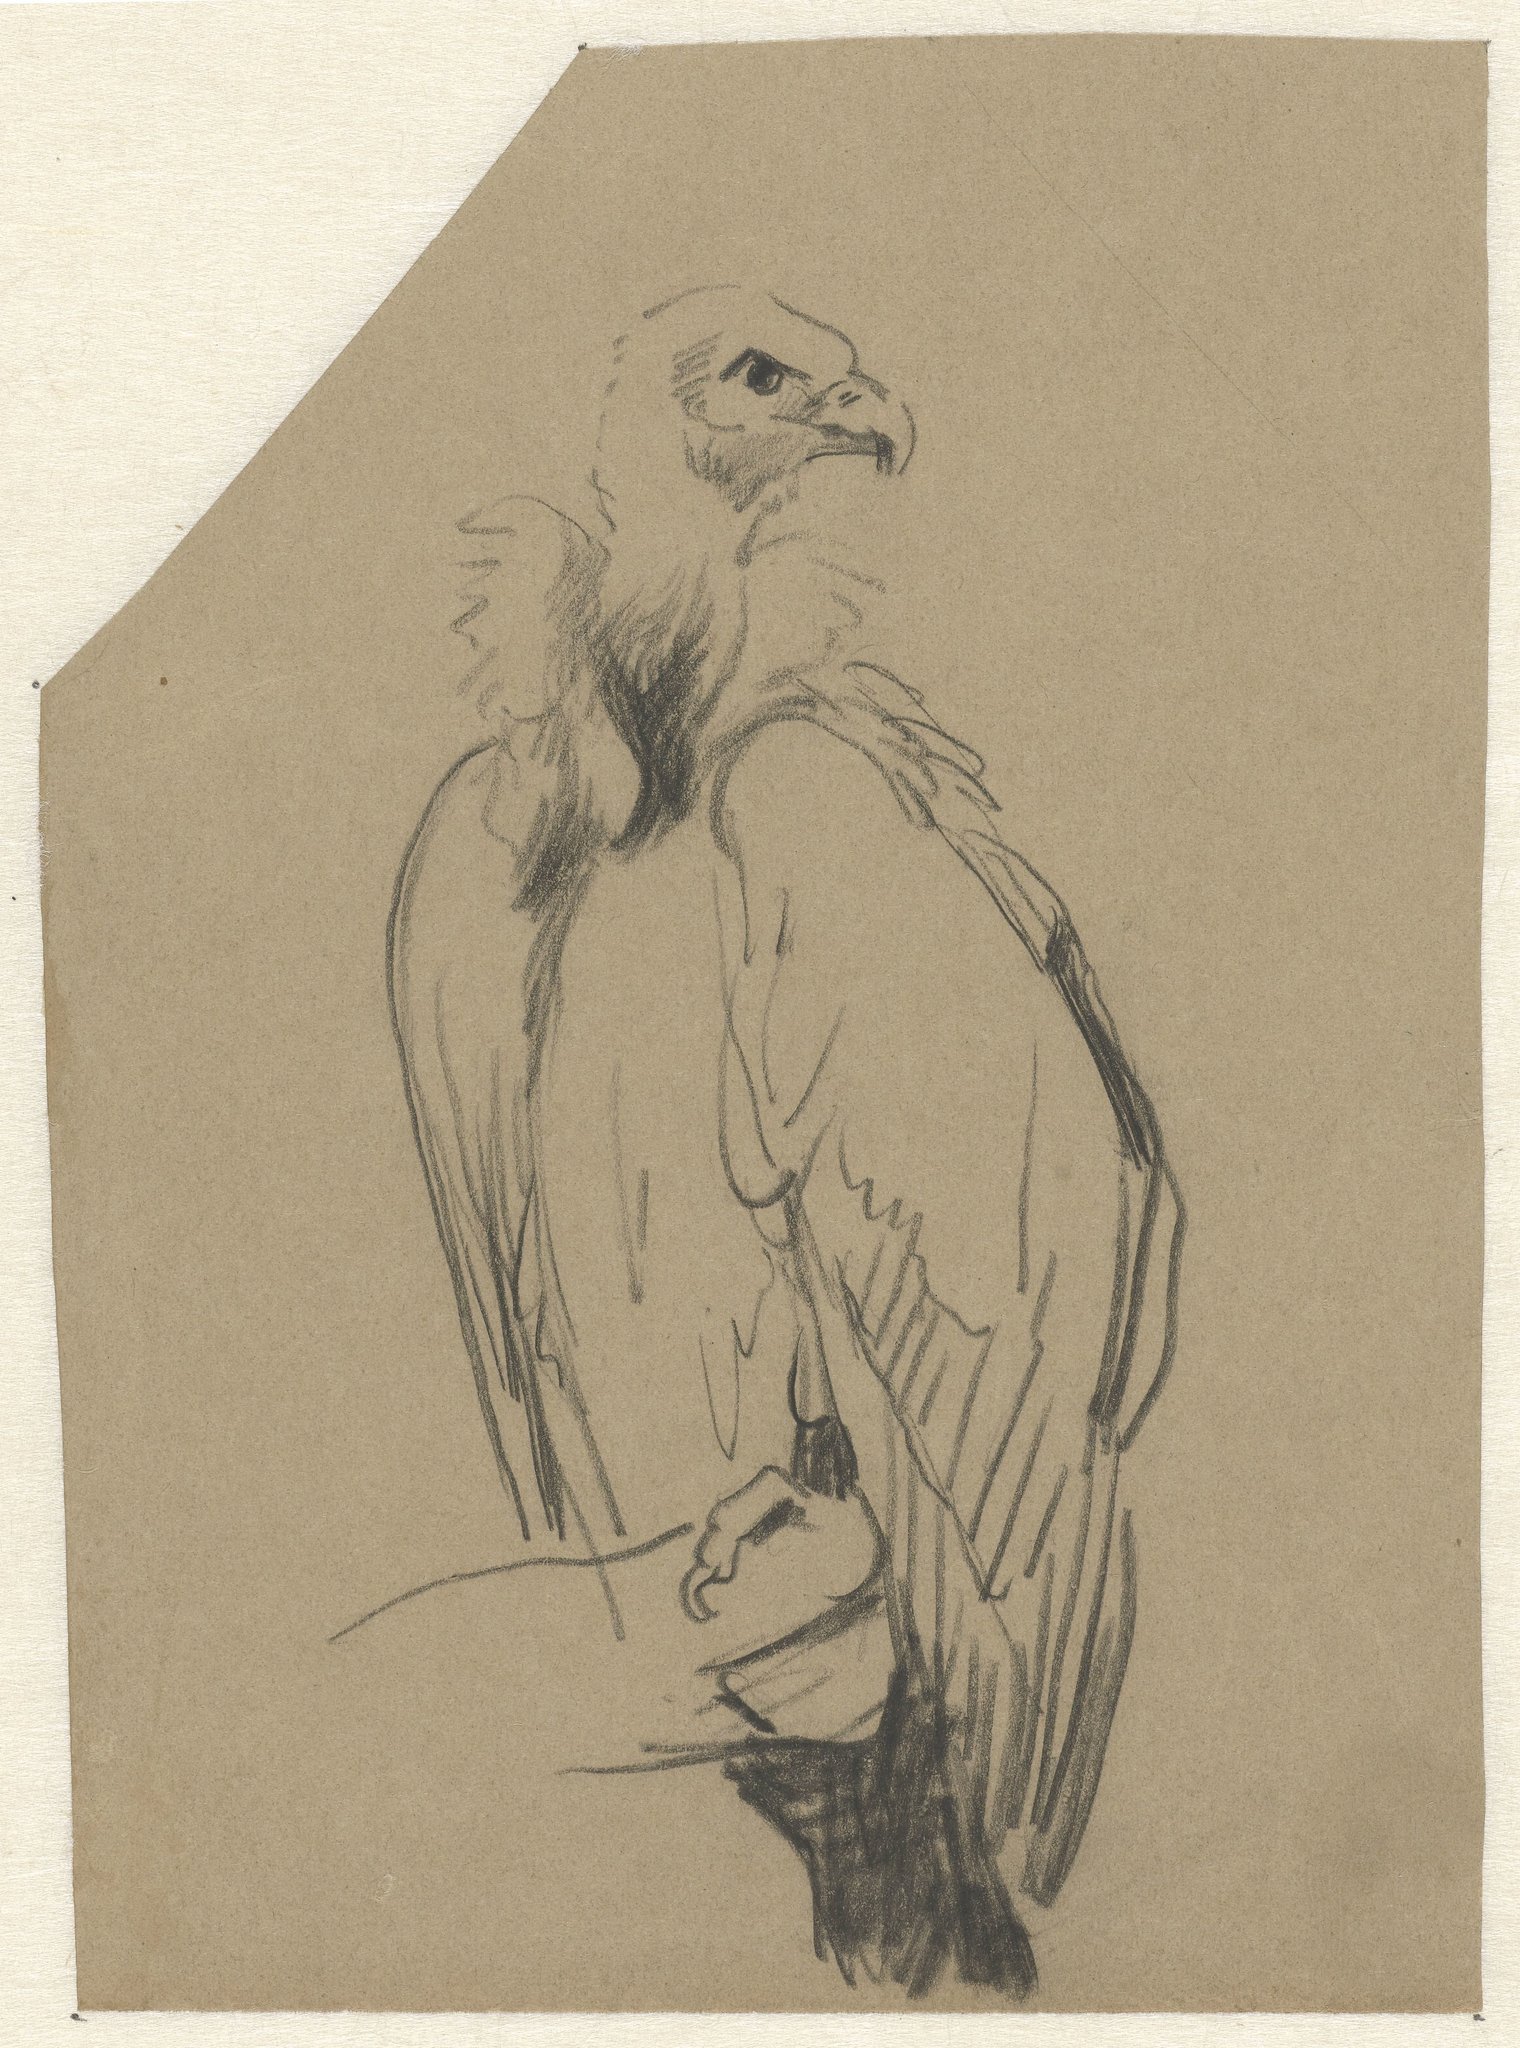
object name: drawing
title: Kraaggier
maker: guillaume anne van der brugghen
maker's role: draughtsman, print maker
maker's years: 1812-1891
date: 1821-1891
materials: chalk, paper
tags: predatory birds: vulture